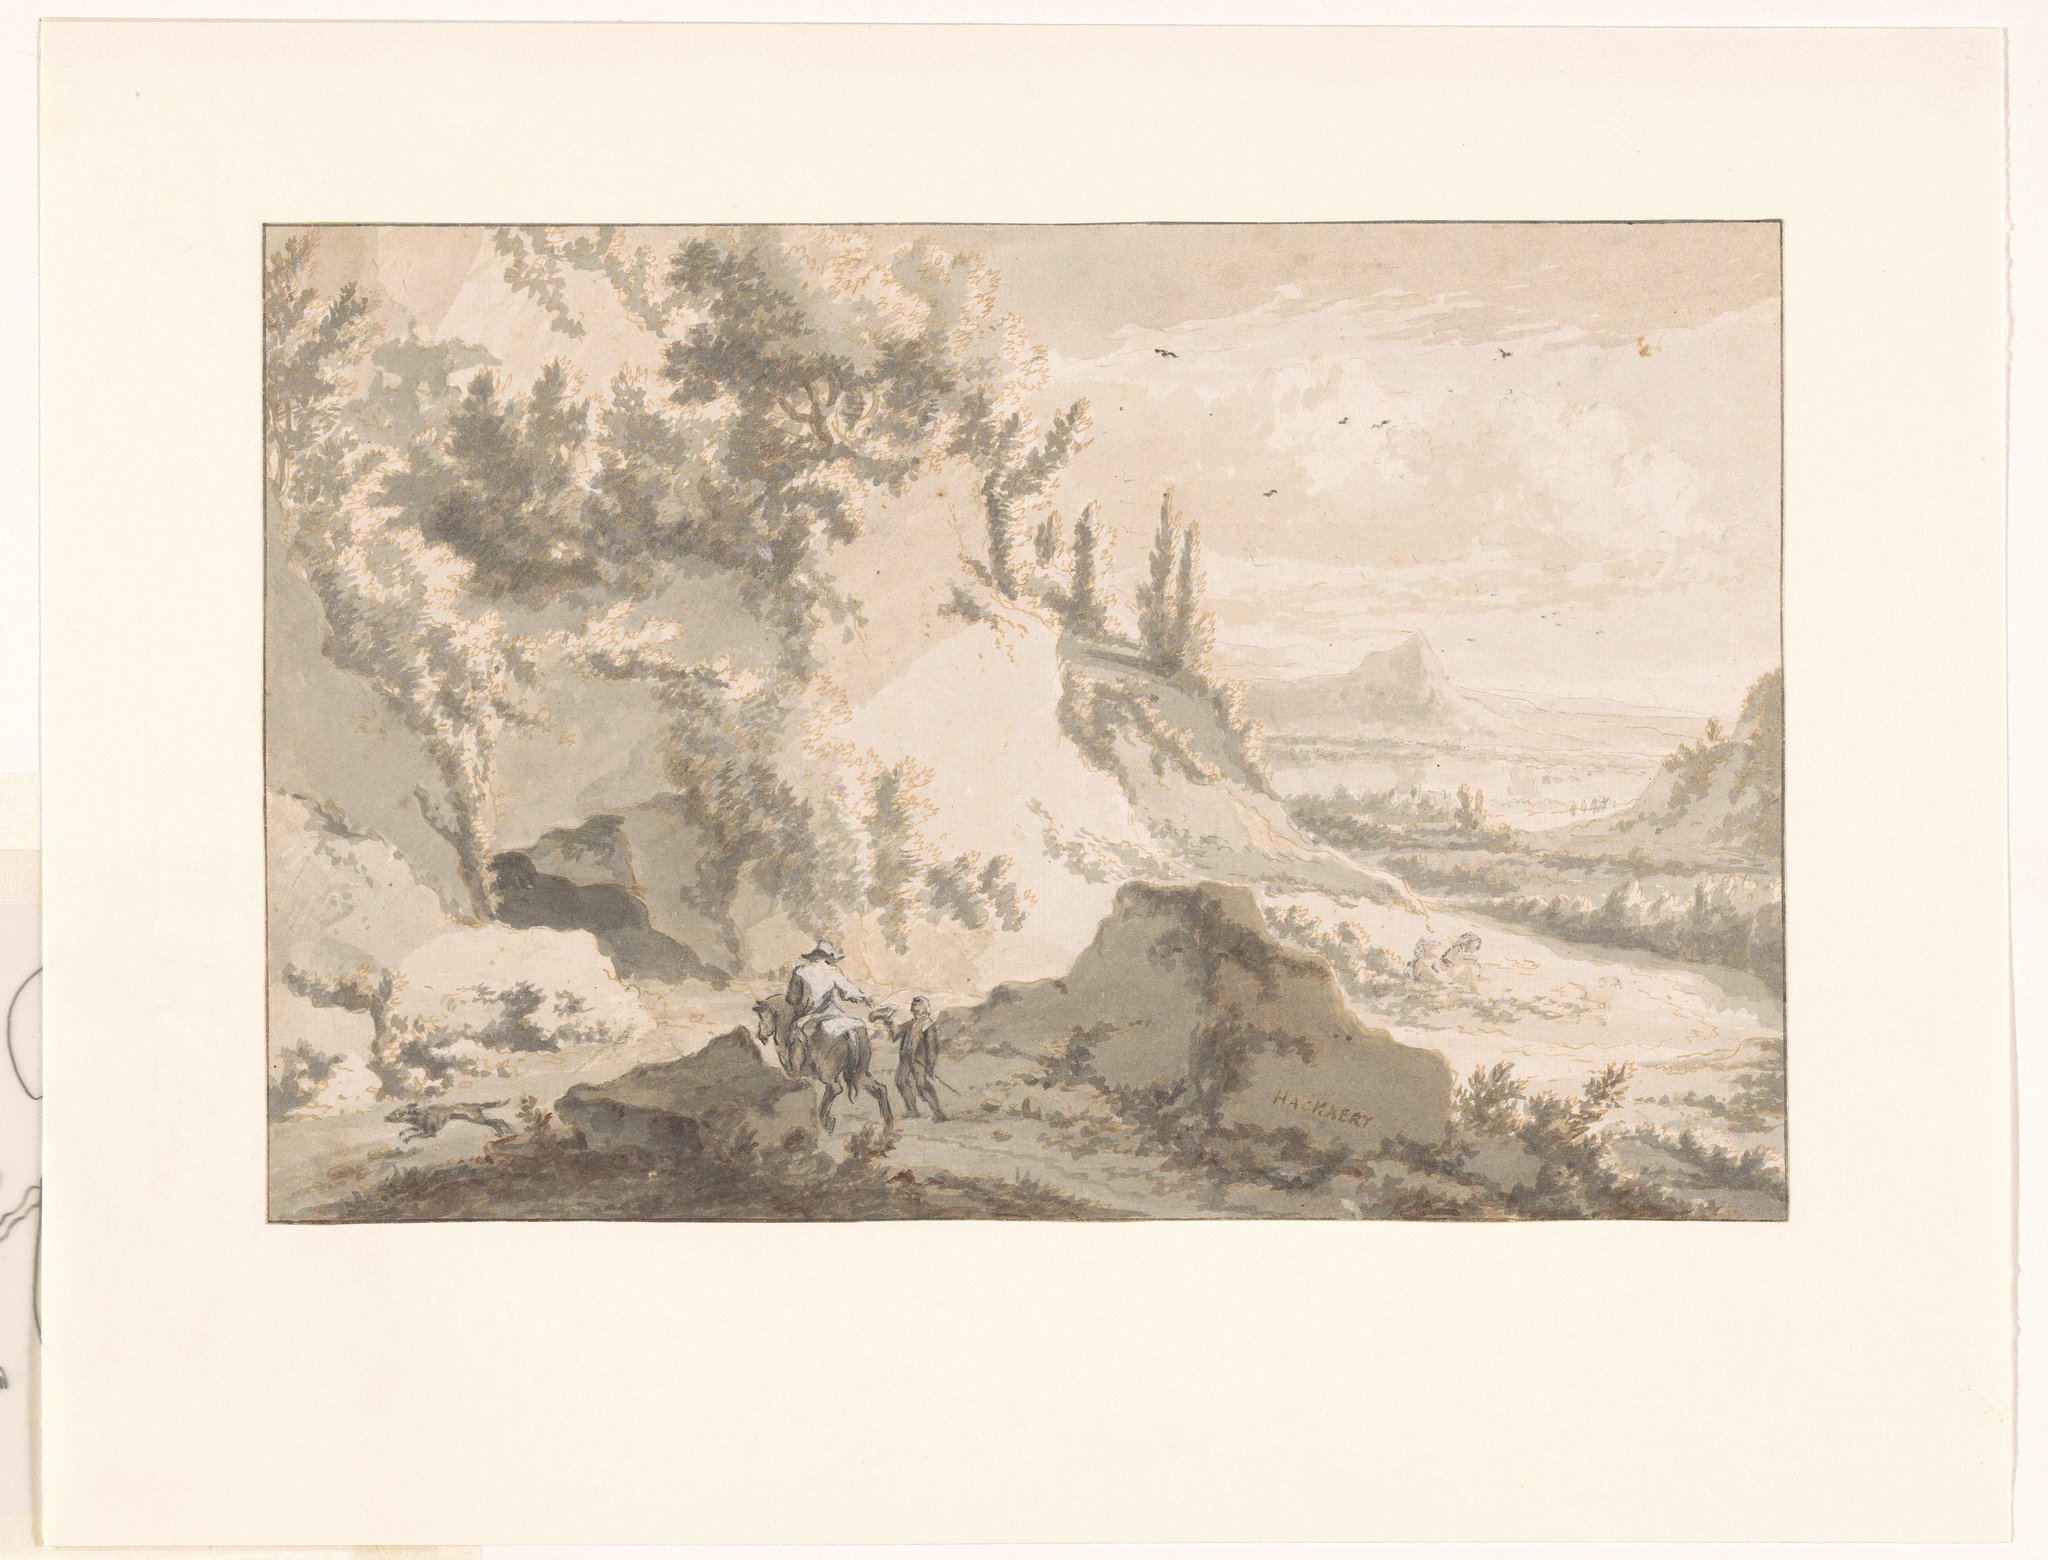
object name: drawing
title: Mountain Landscape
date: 1668-1672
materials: chalk, ink, paper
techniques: brush, pen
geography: amsterdam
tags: landscapes in the temperate zone, beggar